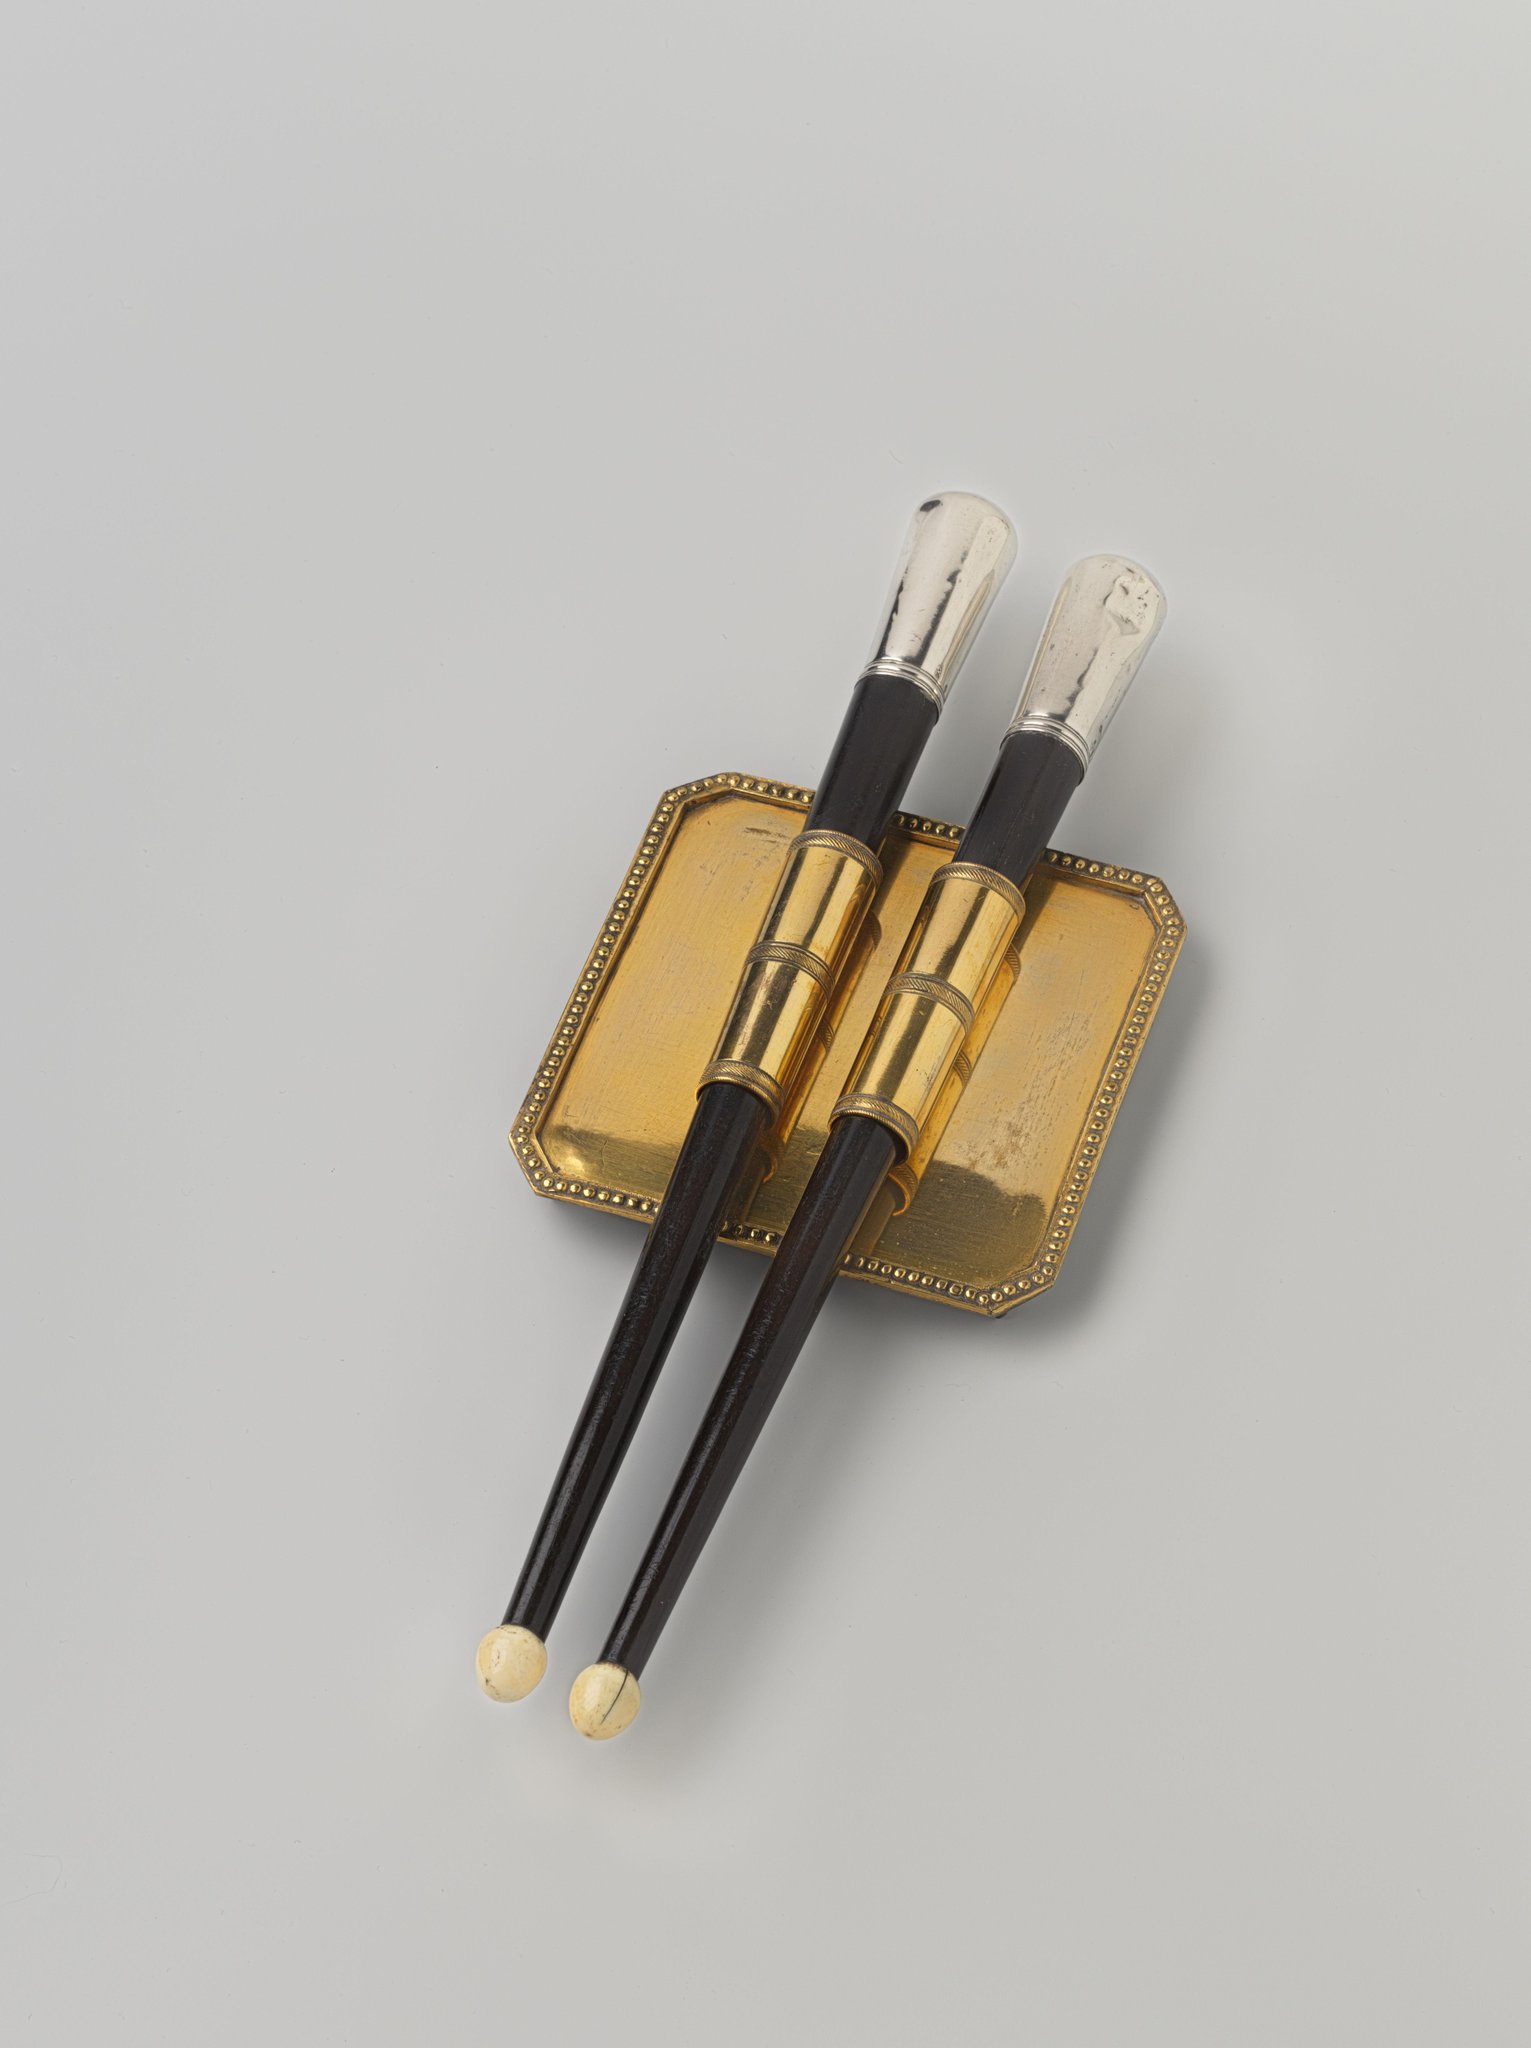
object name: stick plate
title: Stokplaat van verguld koper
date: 1823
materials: copper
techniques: gilding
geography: netherlands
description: Stokplaat voor een slagband van een tamboer-majoor.